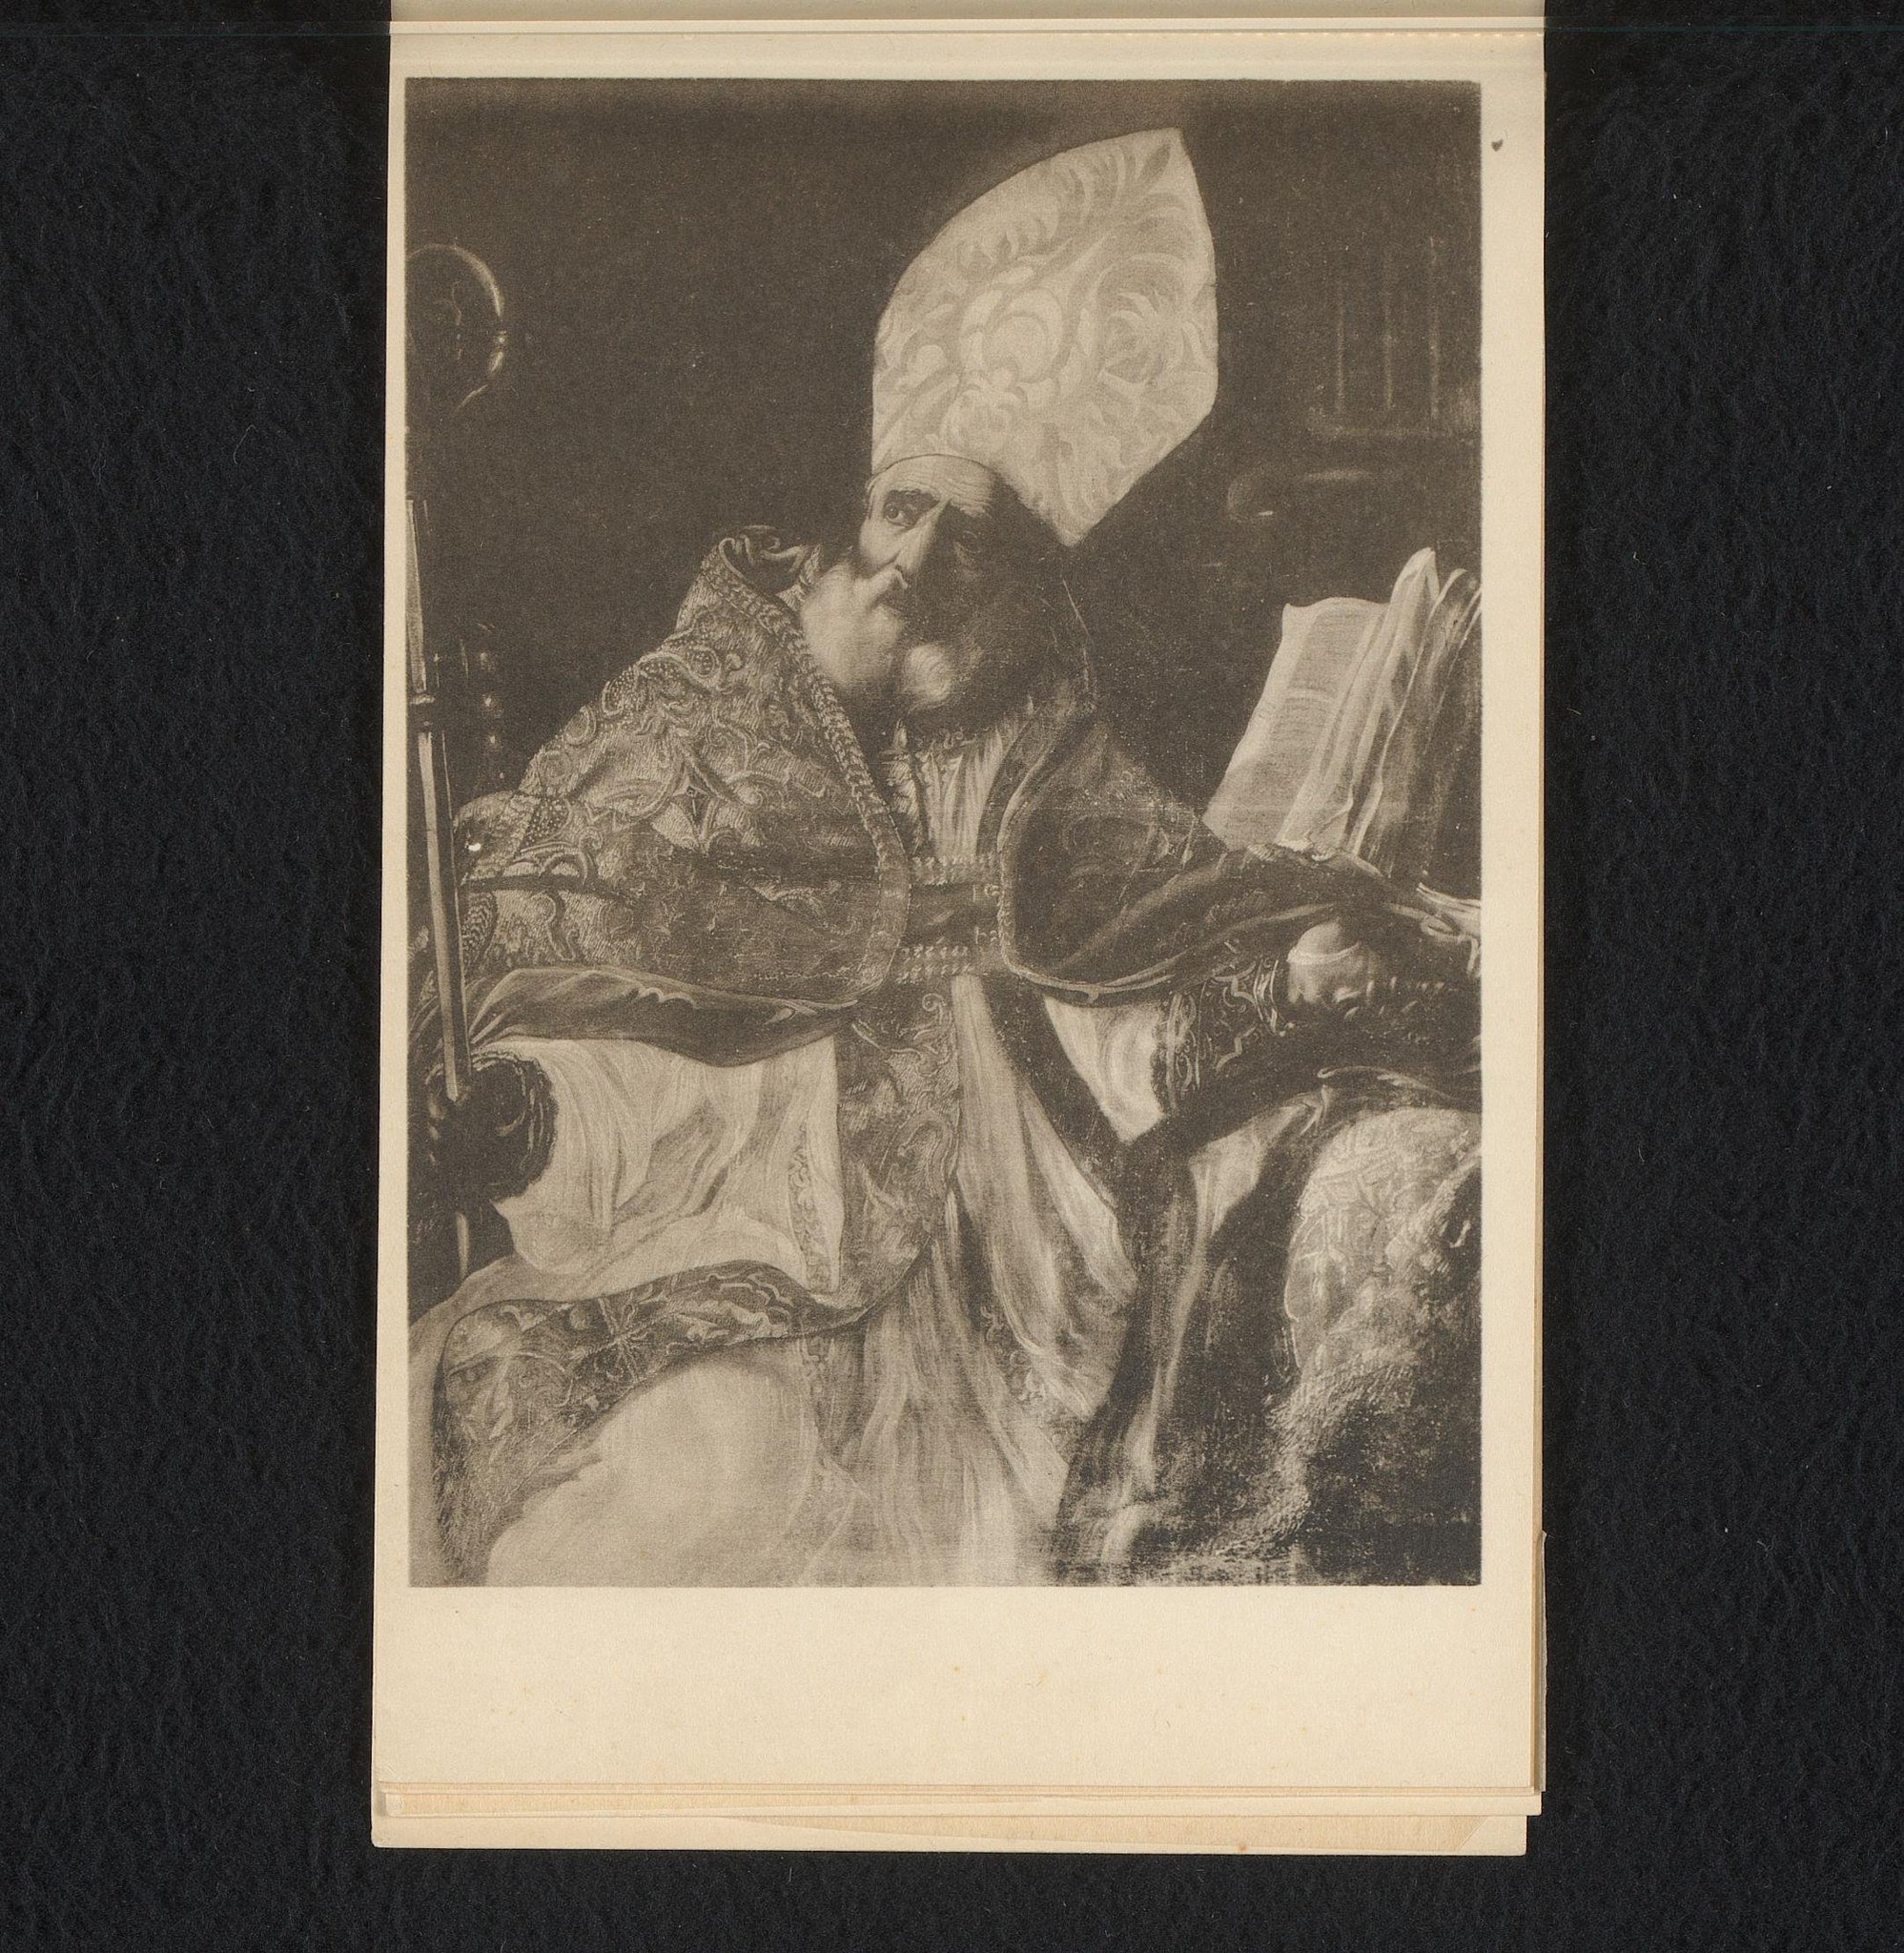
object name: reproduction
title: Museo Cerralbo. Madrid. San Ambrosio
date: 1924-1930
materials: cardboard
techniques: photograph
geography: madrid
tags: permanent exhibition, museum, picture, painting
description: Prentbriefkaart maakt deel uit van een album.